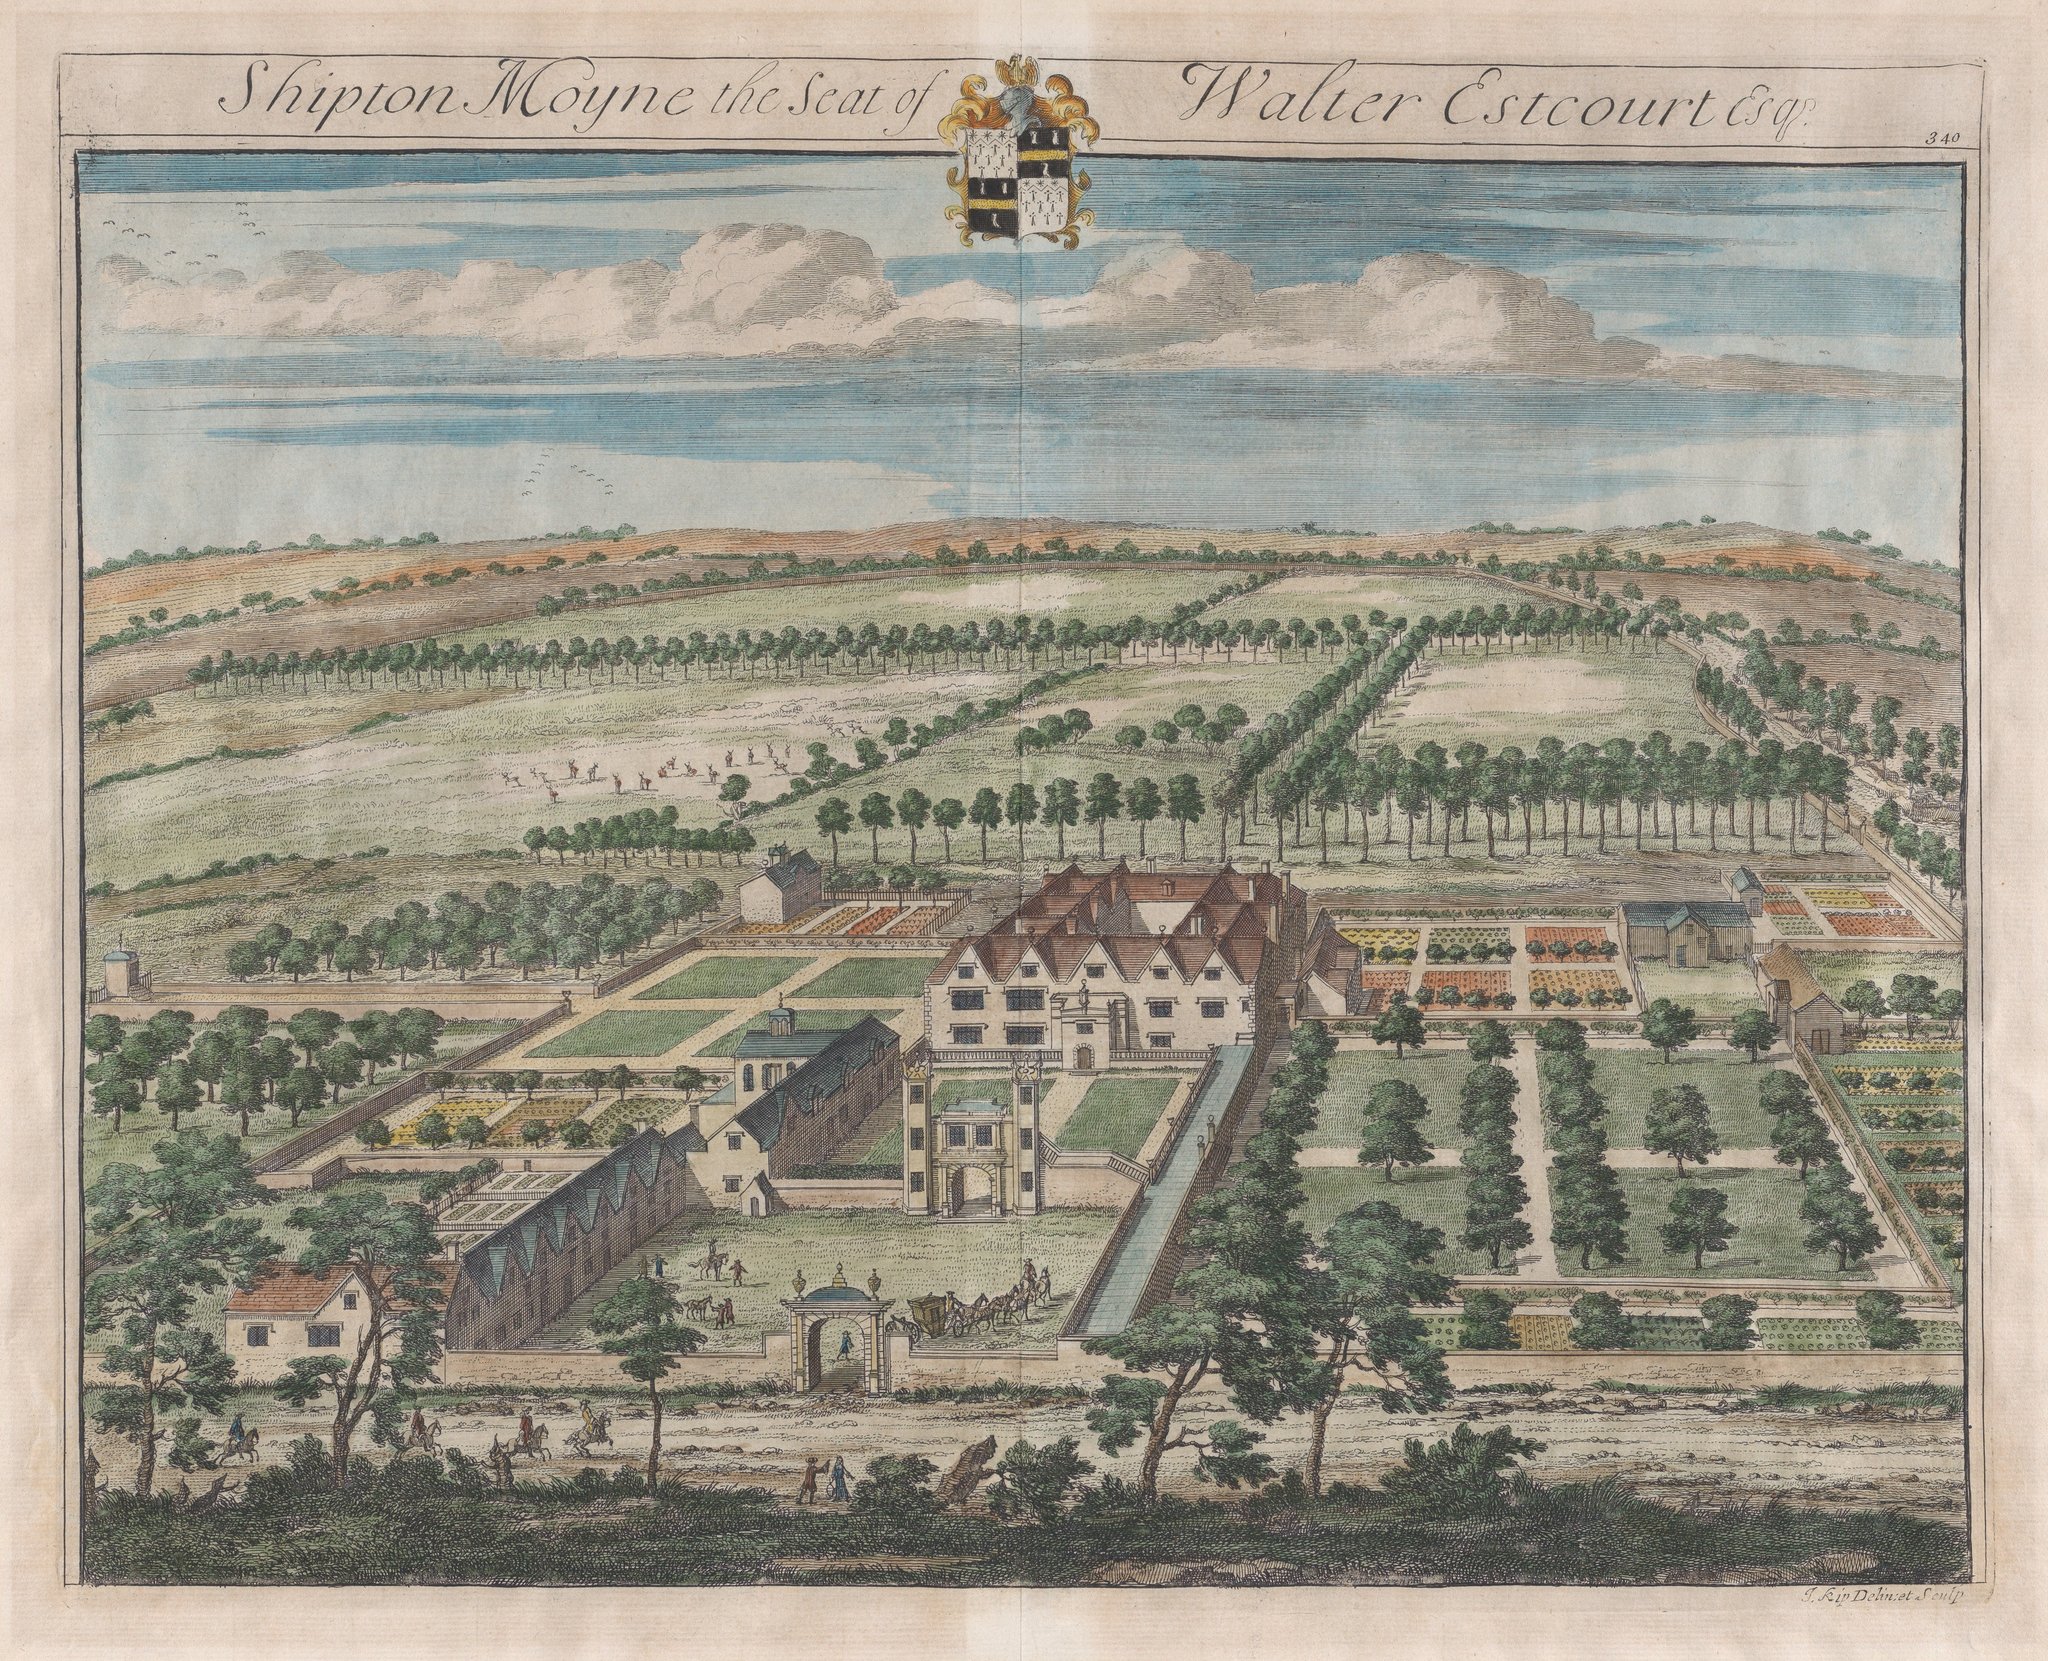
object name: print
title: Shipton Moyne, The Seat of Walter Estcourt, Esq., plate 340 from "The Ancient and Present State of Gloucestershire"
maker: johannes kip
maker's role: artist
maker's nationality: dutch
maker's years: 1653-1722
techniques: engraving, etching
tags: houses,gardens,landscapes,coat of arms